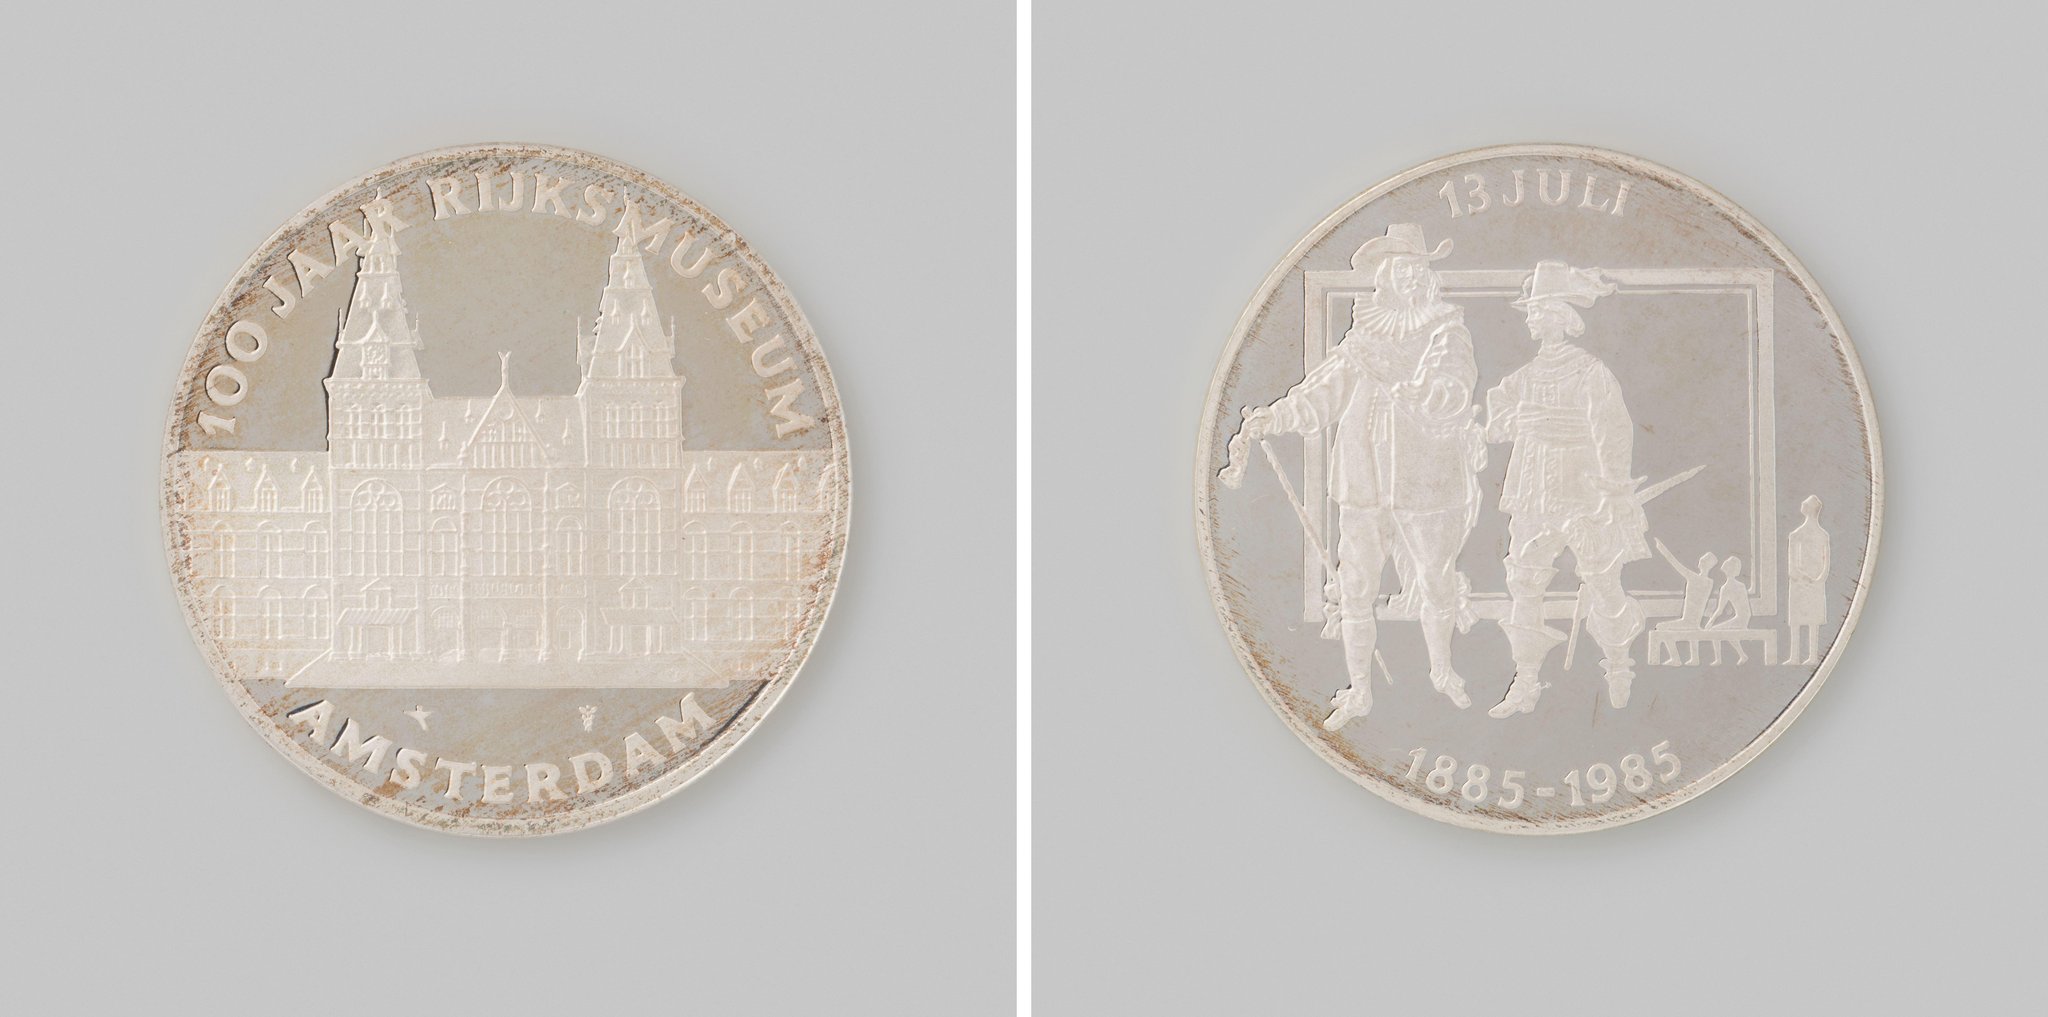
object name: medal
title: Penning van zilver met het Rijksmuseum in rond doosje van perspex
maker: willem vis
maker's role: sculptor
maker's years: 1936-2007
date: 1985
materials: plastic, silver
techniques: striking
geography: utrecht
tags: rijksmuseum amsterdam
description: Voorzijde: voorgevel Rijksmuseum binnen opschrift ('100 jaar Rijksmuseum / Amsterdam'), met onder muntmeesterteken en muntteken; aambeeld (boven S) en mercuriusstaf (boven D)) en rechtsonder (onder rechtertoren) signatuur medailleur. Keerzijde: de twee hoofdpersonen uit De Nachtwacht voor schilderijlijst met rechts drie bezoekers, twee zittend, een staand, binnen omschrift ('13 juli / 1885-1985').